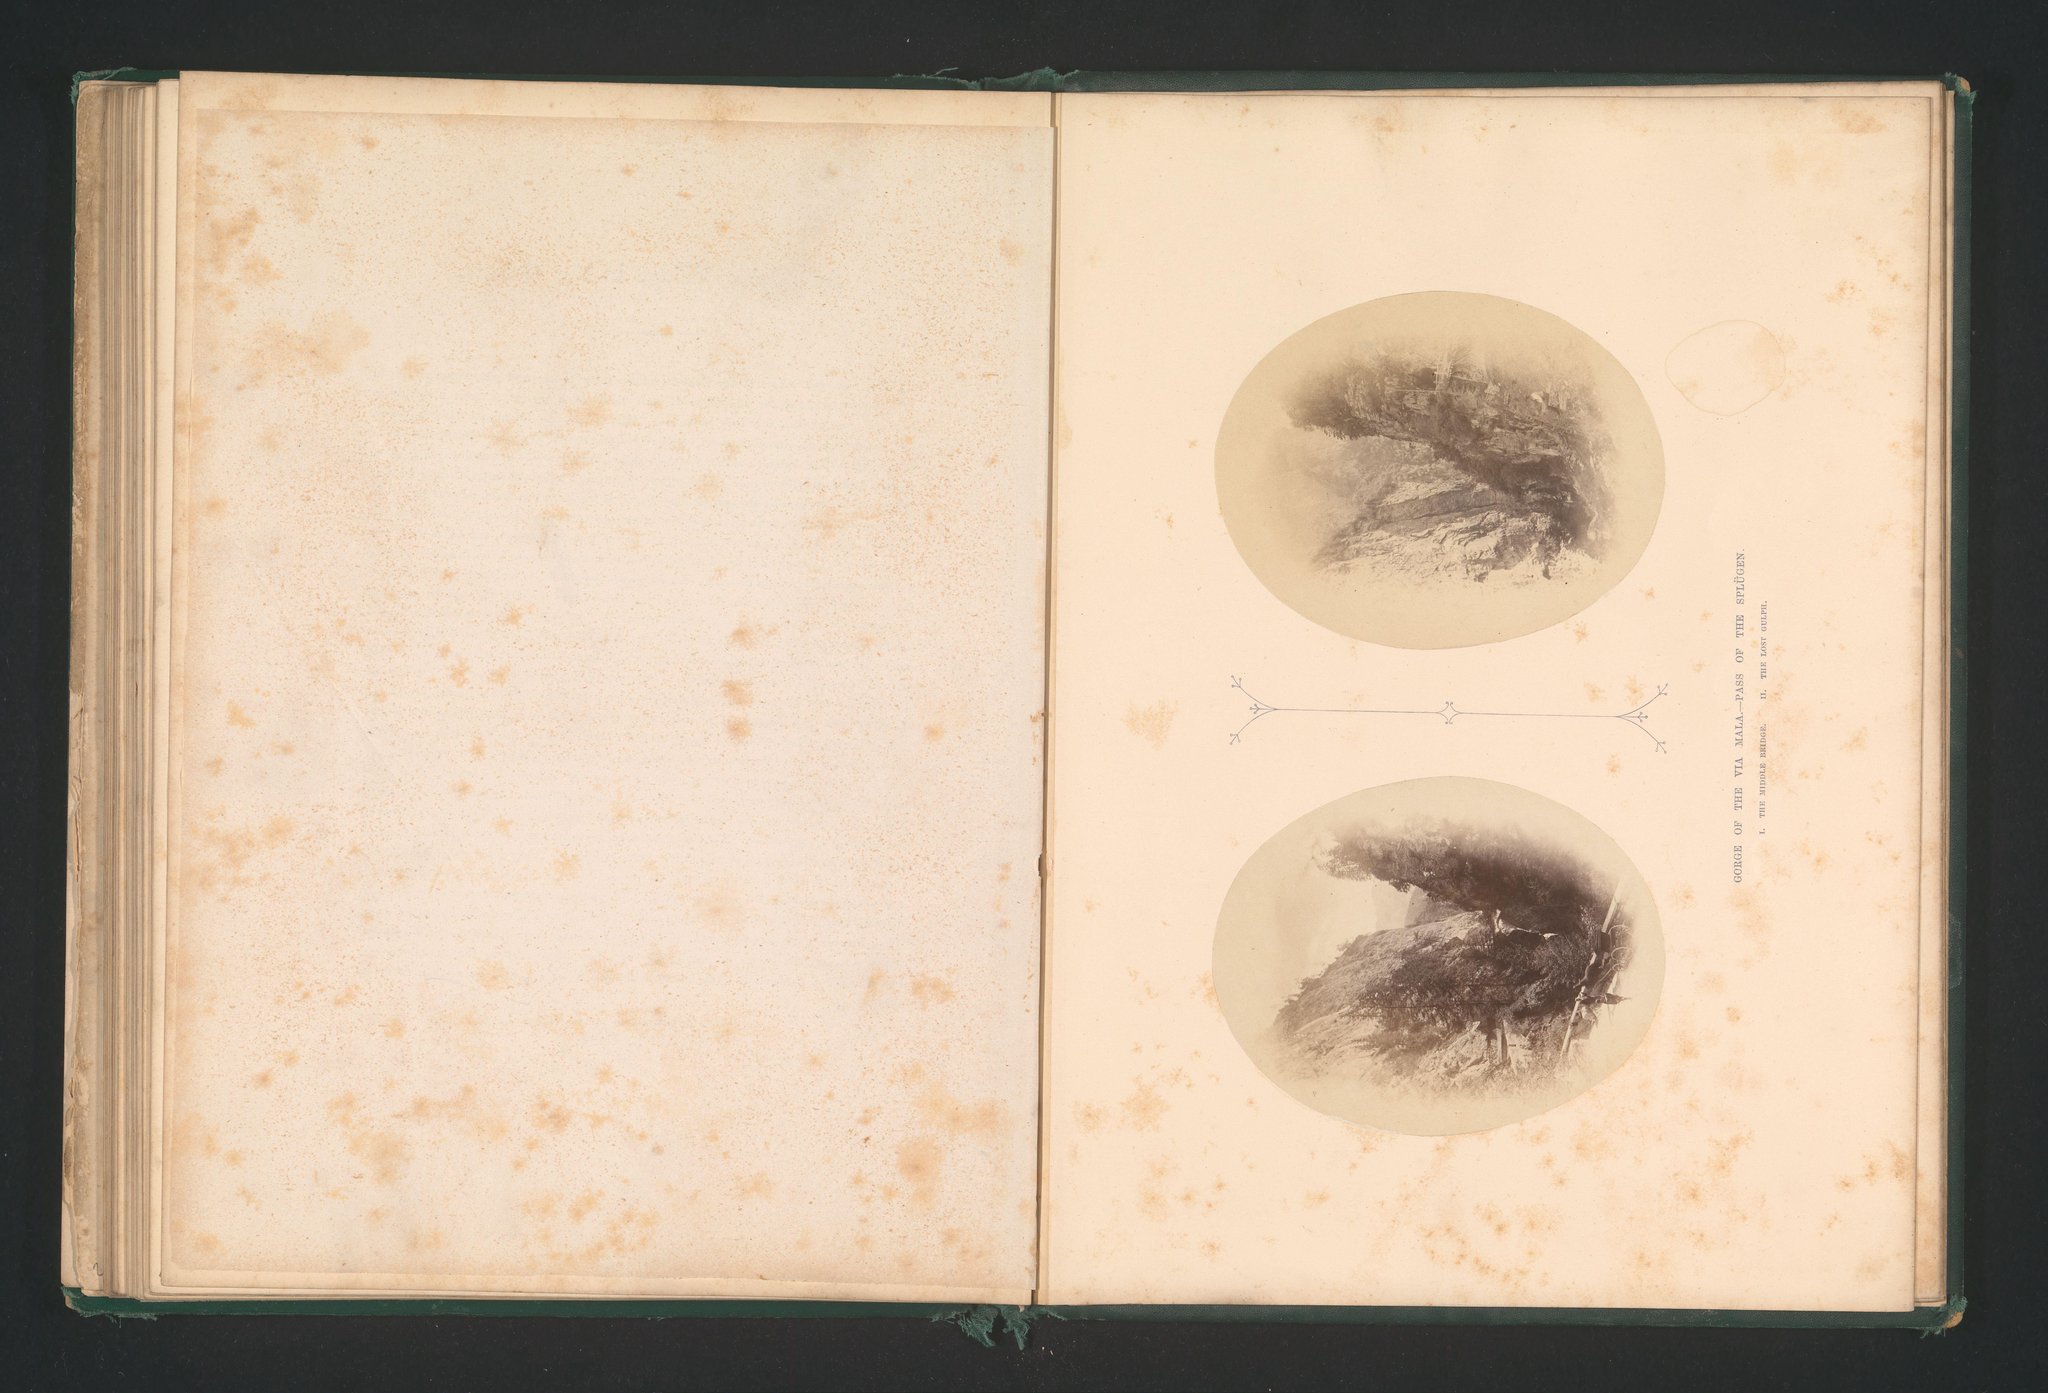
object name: photograph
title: Gezicht op de Via Mala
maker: stephen thompson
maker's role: fotograaf, schrijver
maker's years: 1831-1893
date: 1863-1868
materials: photographic support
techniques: albumen print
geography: graubunden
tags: road, path, ravine, chasm, abyss, canyon (+ landscape with figures, staffage)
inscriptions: inscription: ‘I. The middle bridge’